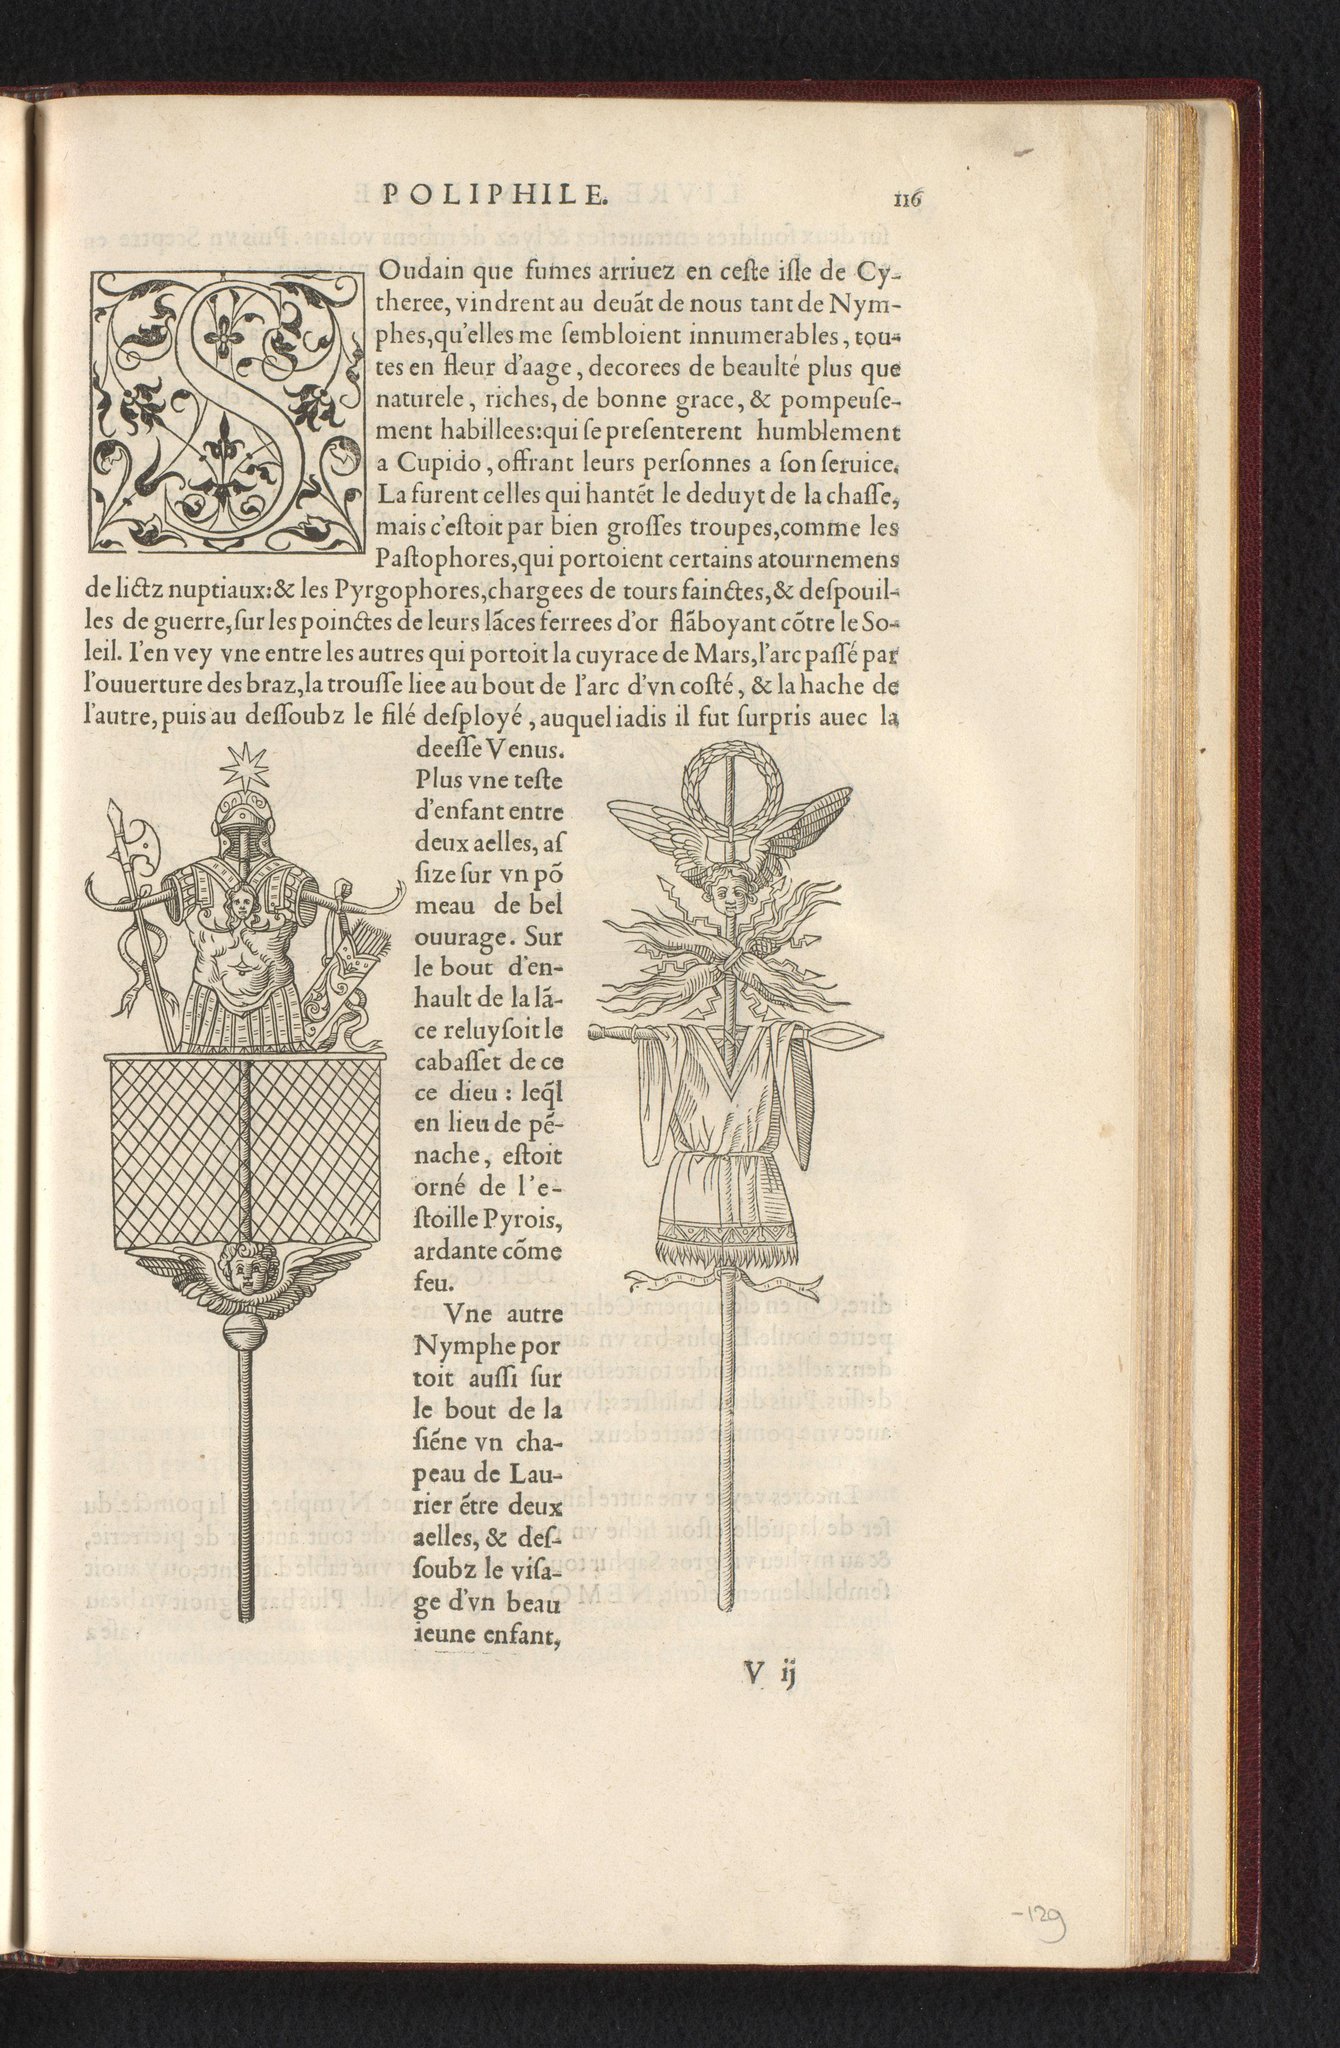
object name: page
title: Twee militaire standaards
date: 1546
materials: paper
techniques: letterpress printing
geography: paris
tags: (scenes from) specific works of literature: colonna, hypnerotomachia poliphili, (military) flags and standards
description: Prent uit: Colonna, Francesco. Hypnerotomachie ou discours du songe de Poliphile, deduisant comme amour le combat a l'occasion de Polia. Parijs: Jacques Kerver, 1546, recto fol. 116.